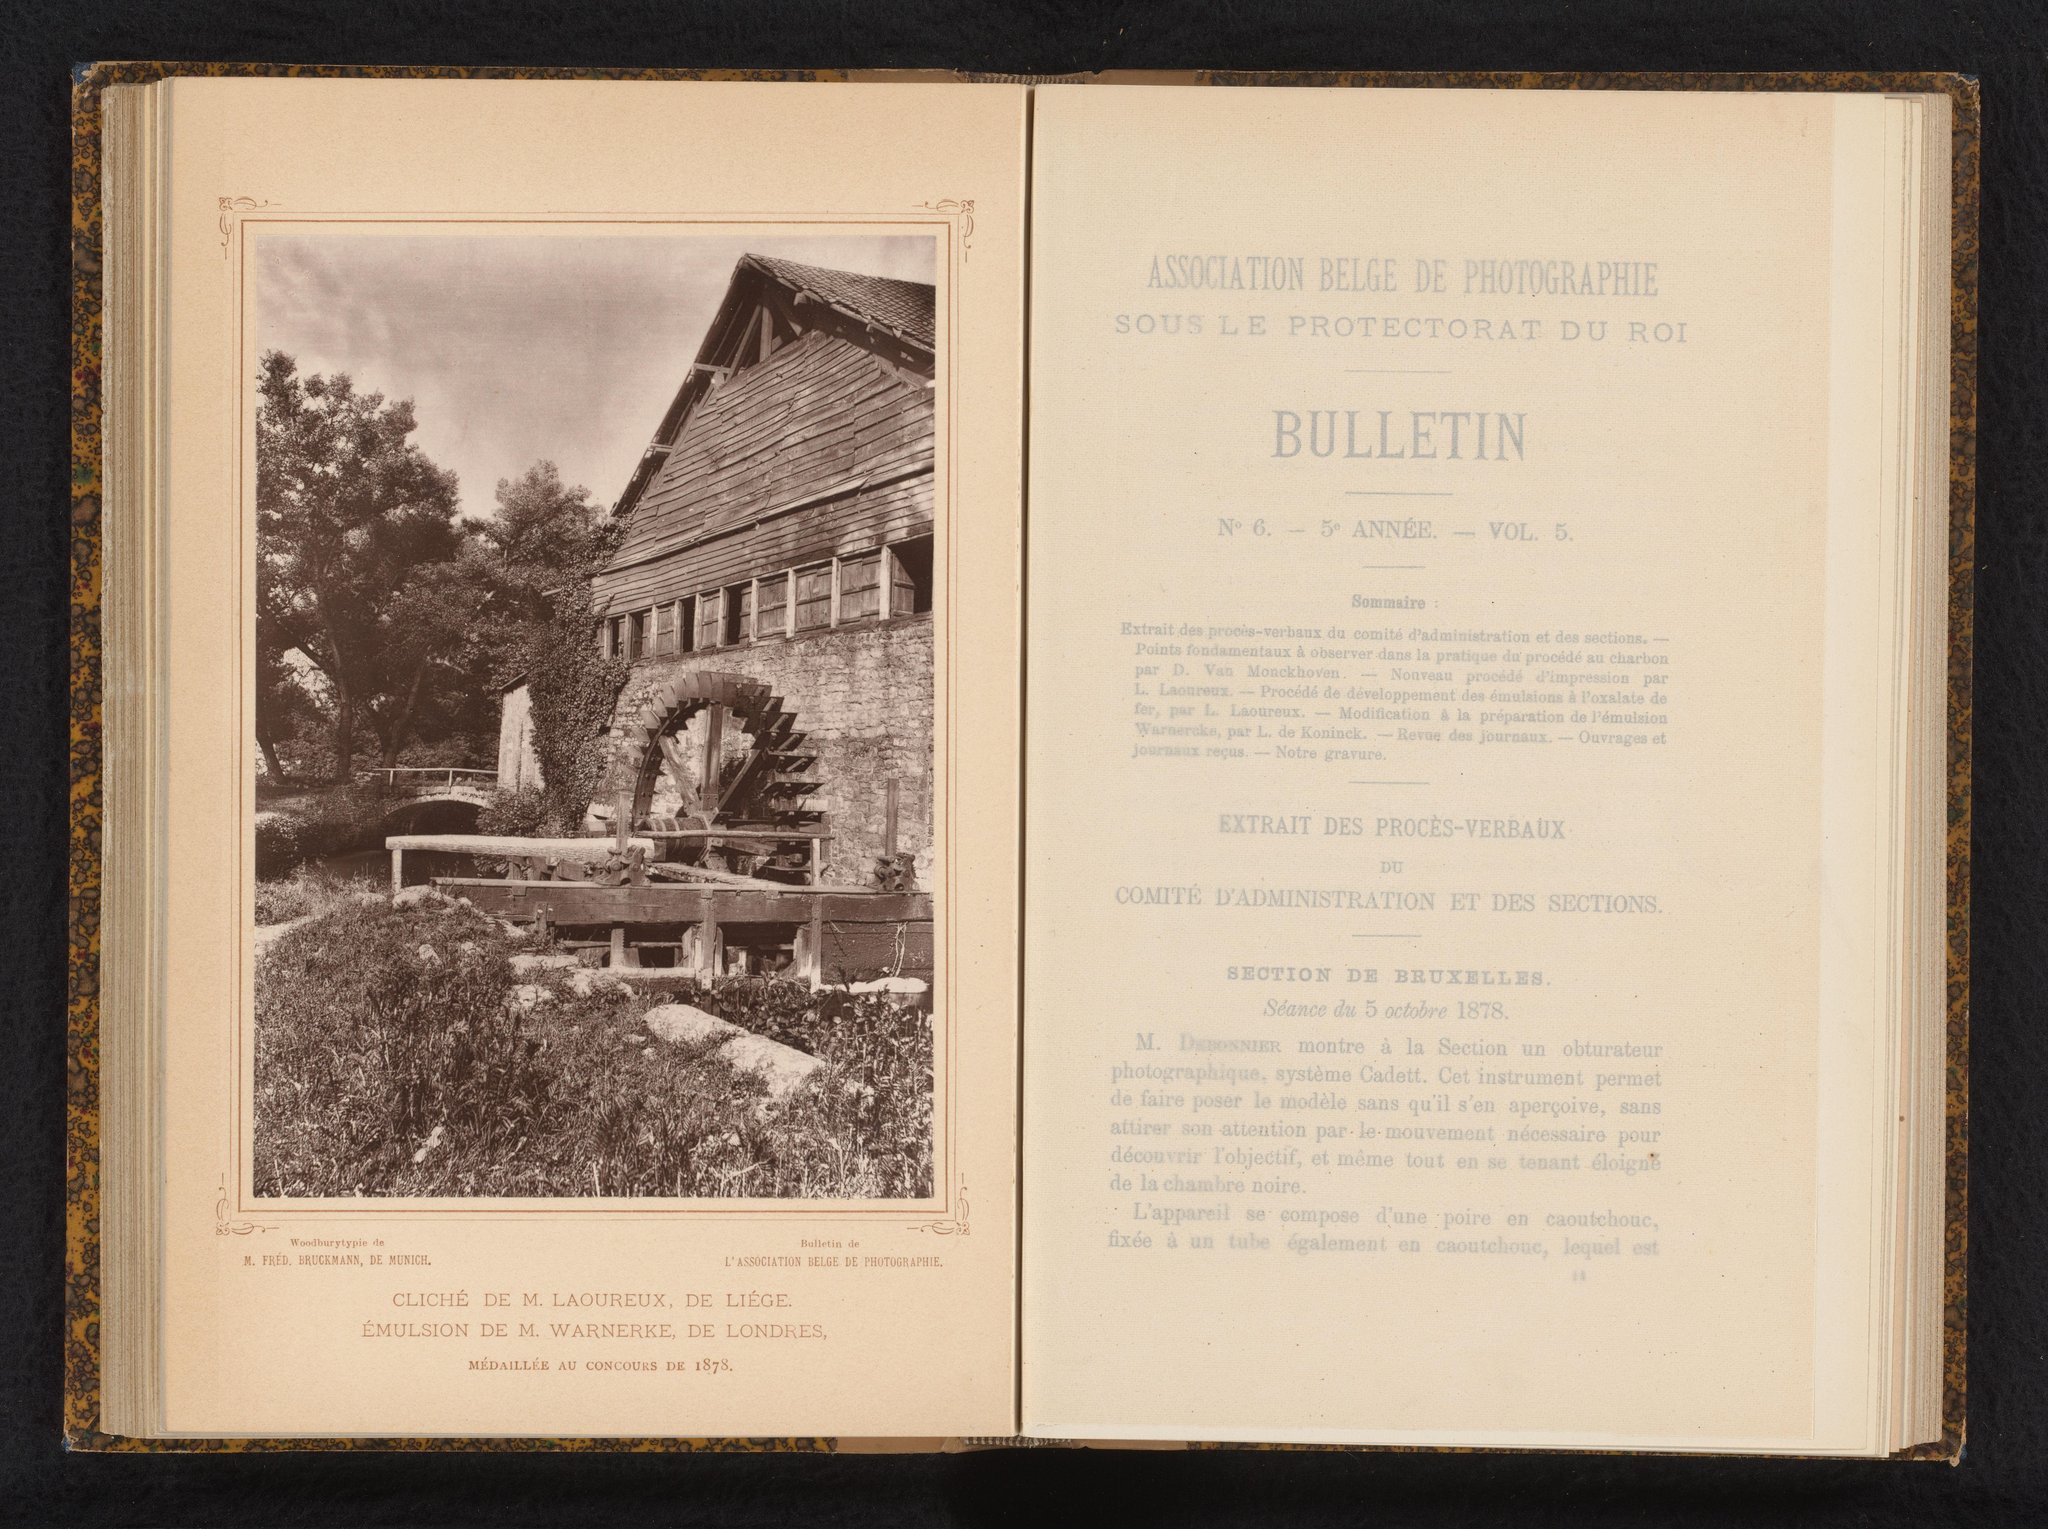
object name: page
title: Gezicht op een gracht in Diksmuide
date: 1874-1879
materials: paper, cardboard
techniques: photograph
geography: diksmuide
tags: canals, waters (in city)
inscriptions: inscription: ‘Procédé au collodion sec’